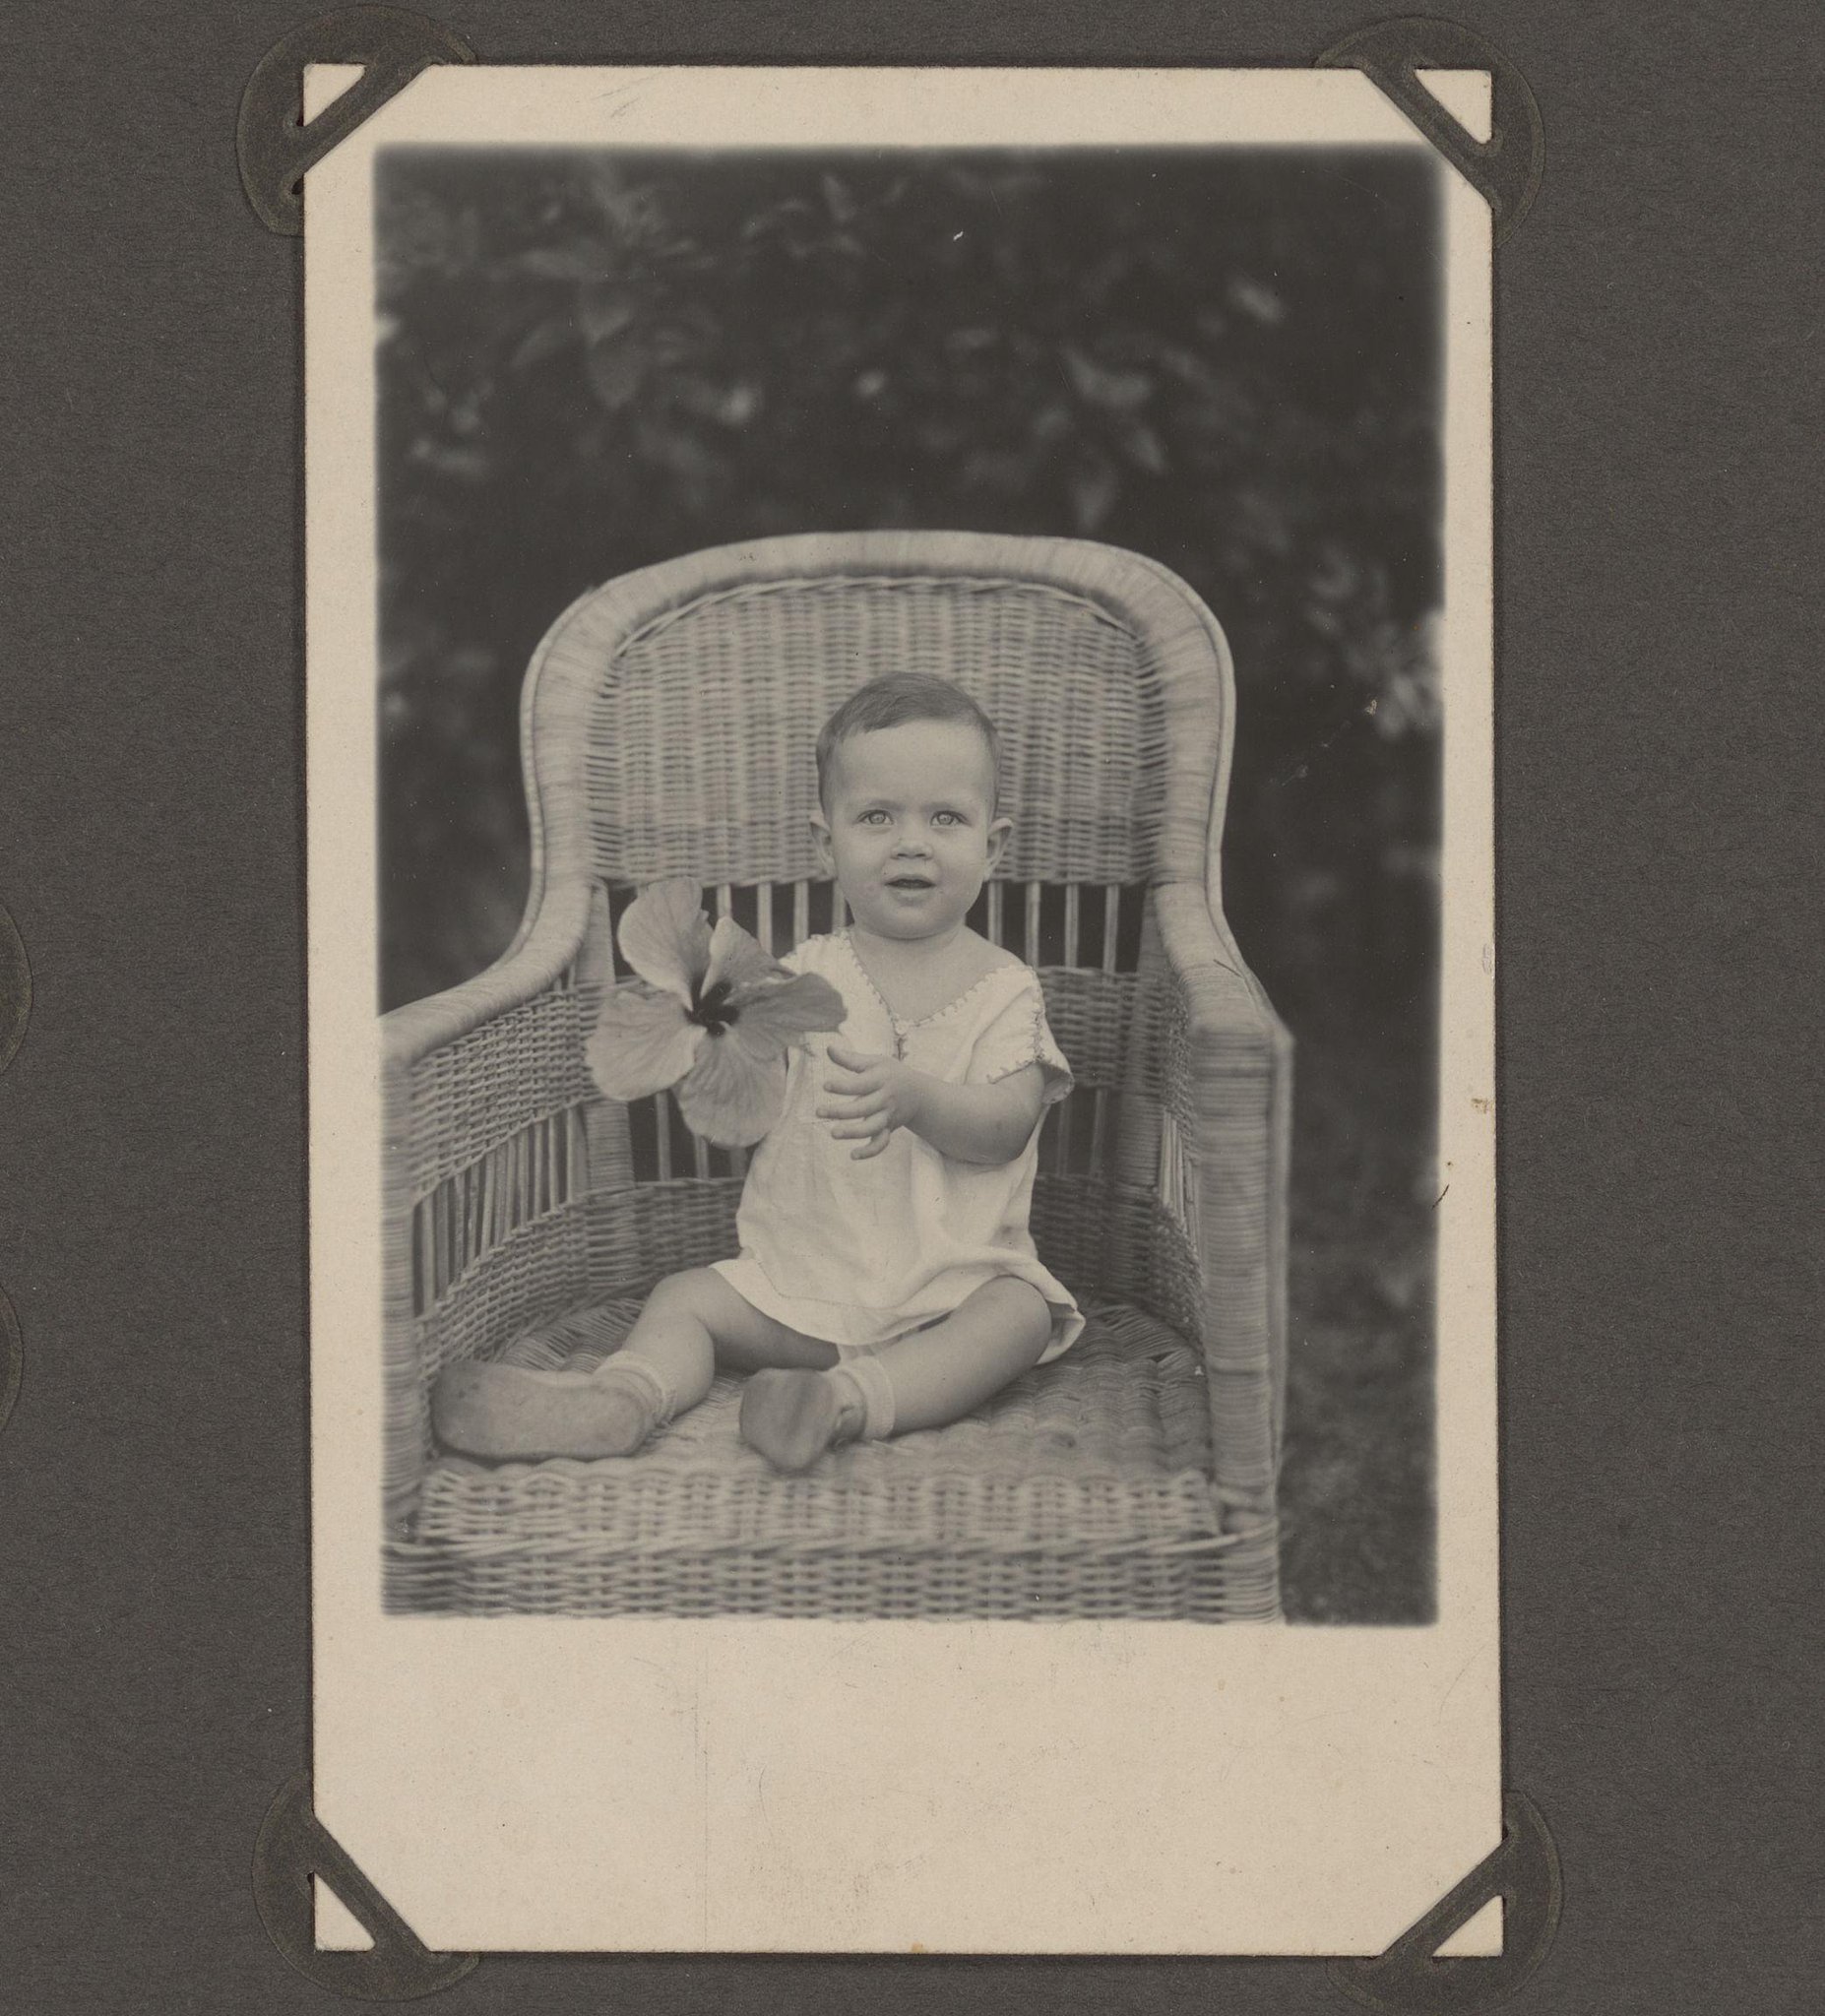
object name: photograph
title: Familiefoto van het gezin Jetten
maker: Anonymous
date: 1925-1927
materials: photographic support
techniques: photography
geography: suriname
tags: jetten, familie, moengo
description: Familiefoto van de kinderen Jetten. Foto op een bladzijde van een los albumblad. Onderdeel van het ensemble met foto's van de familie van ingenieur Jetten in de mijnbouwstad Moengo in Suriname.